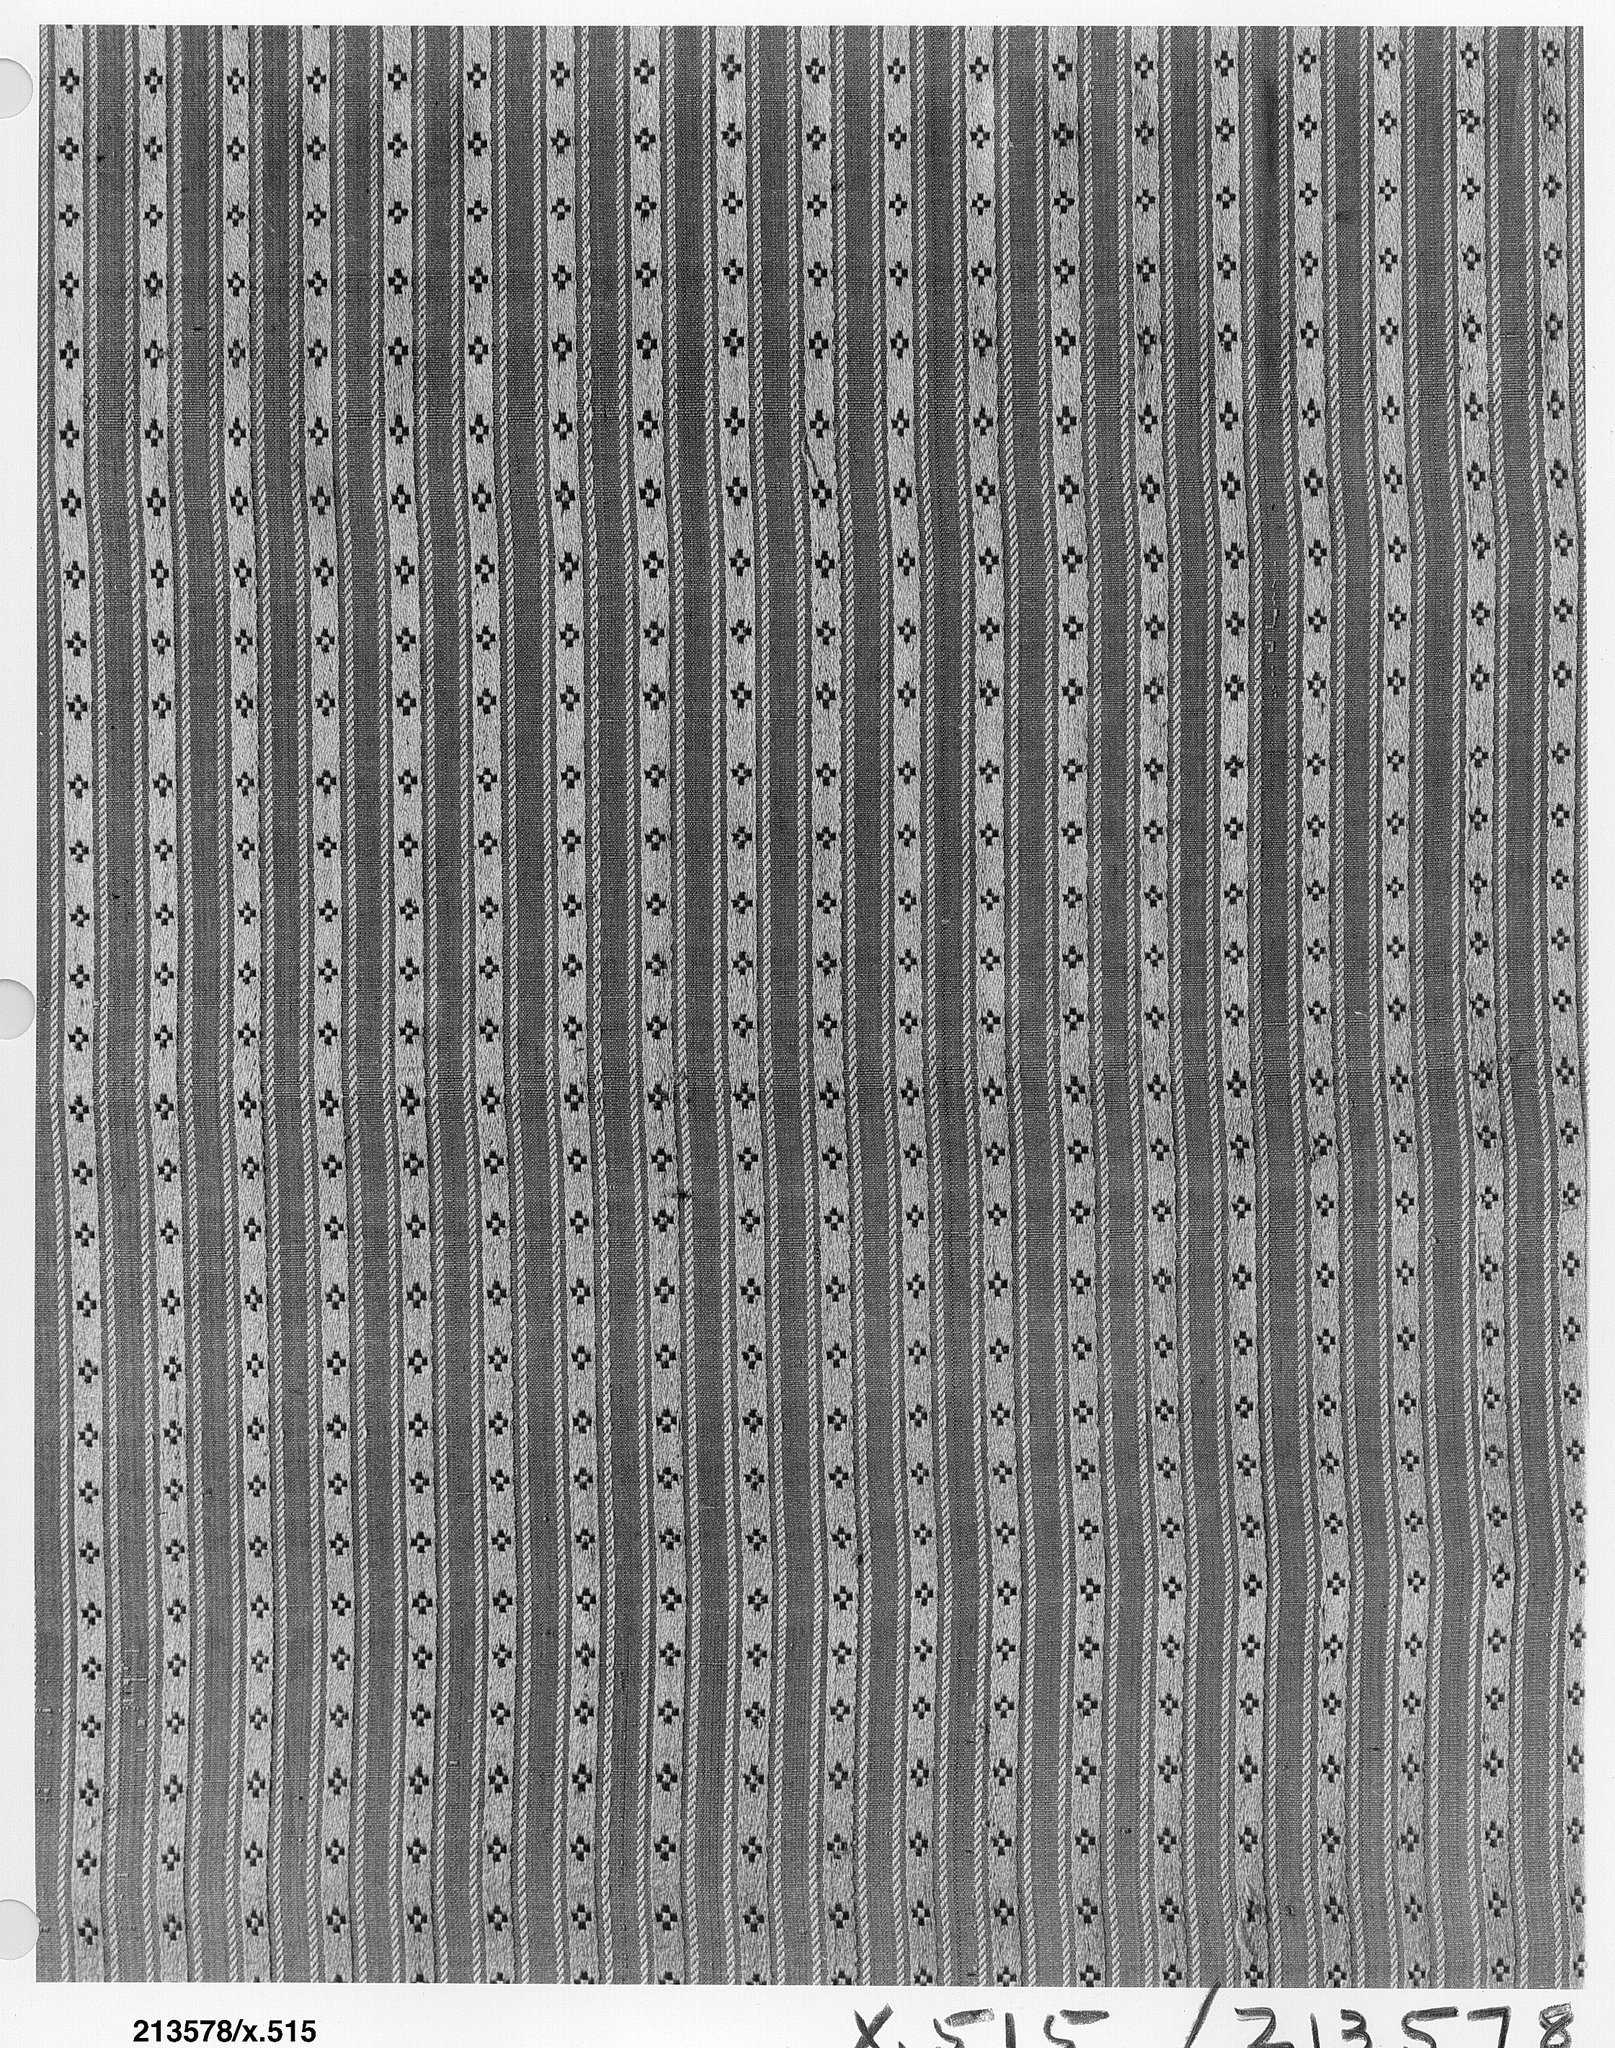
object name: breadth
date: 1701-1800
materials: silk